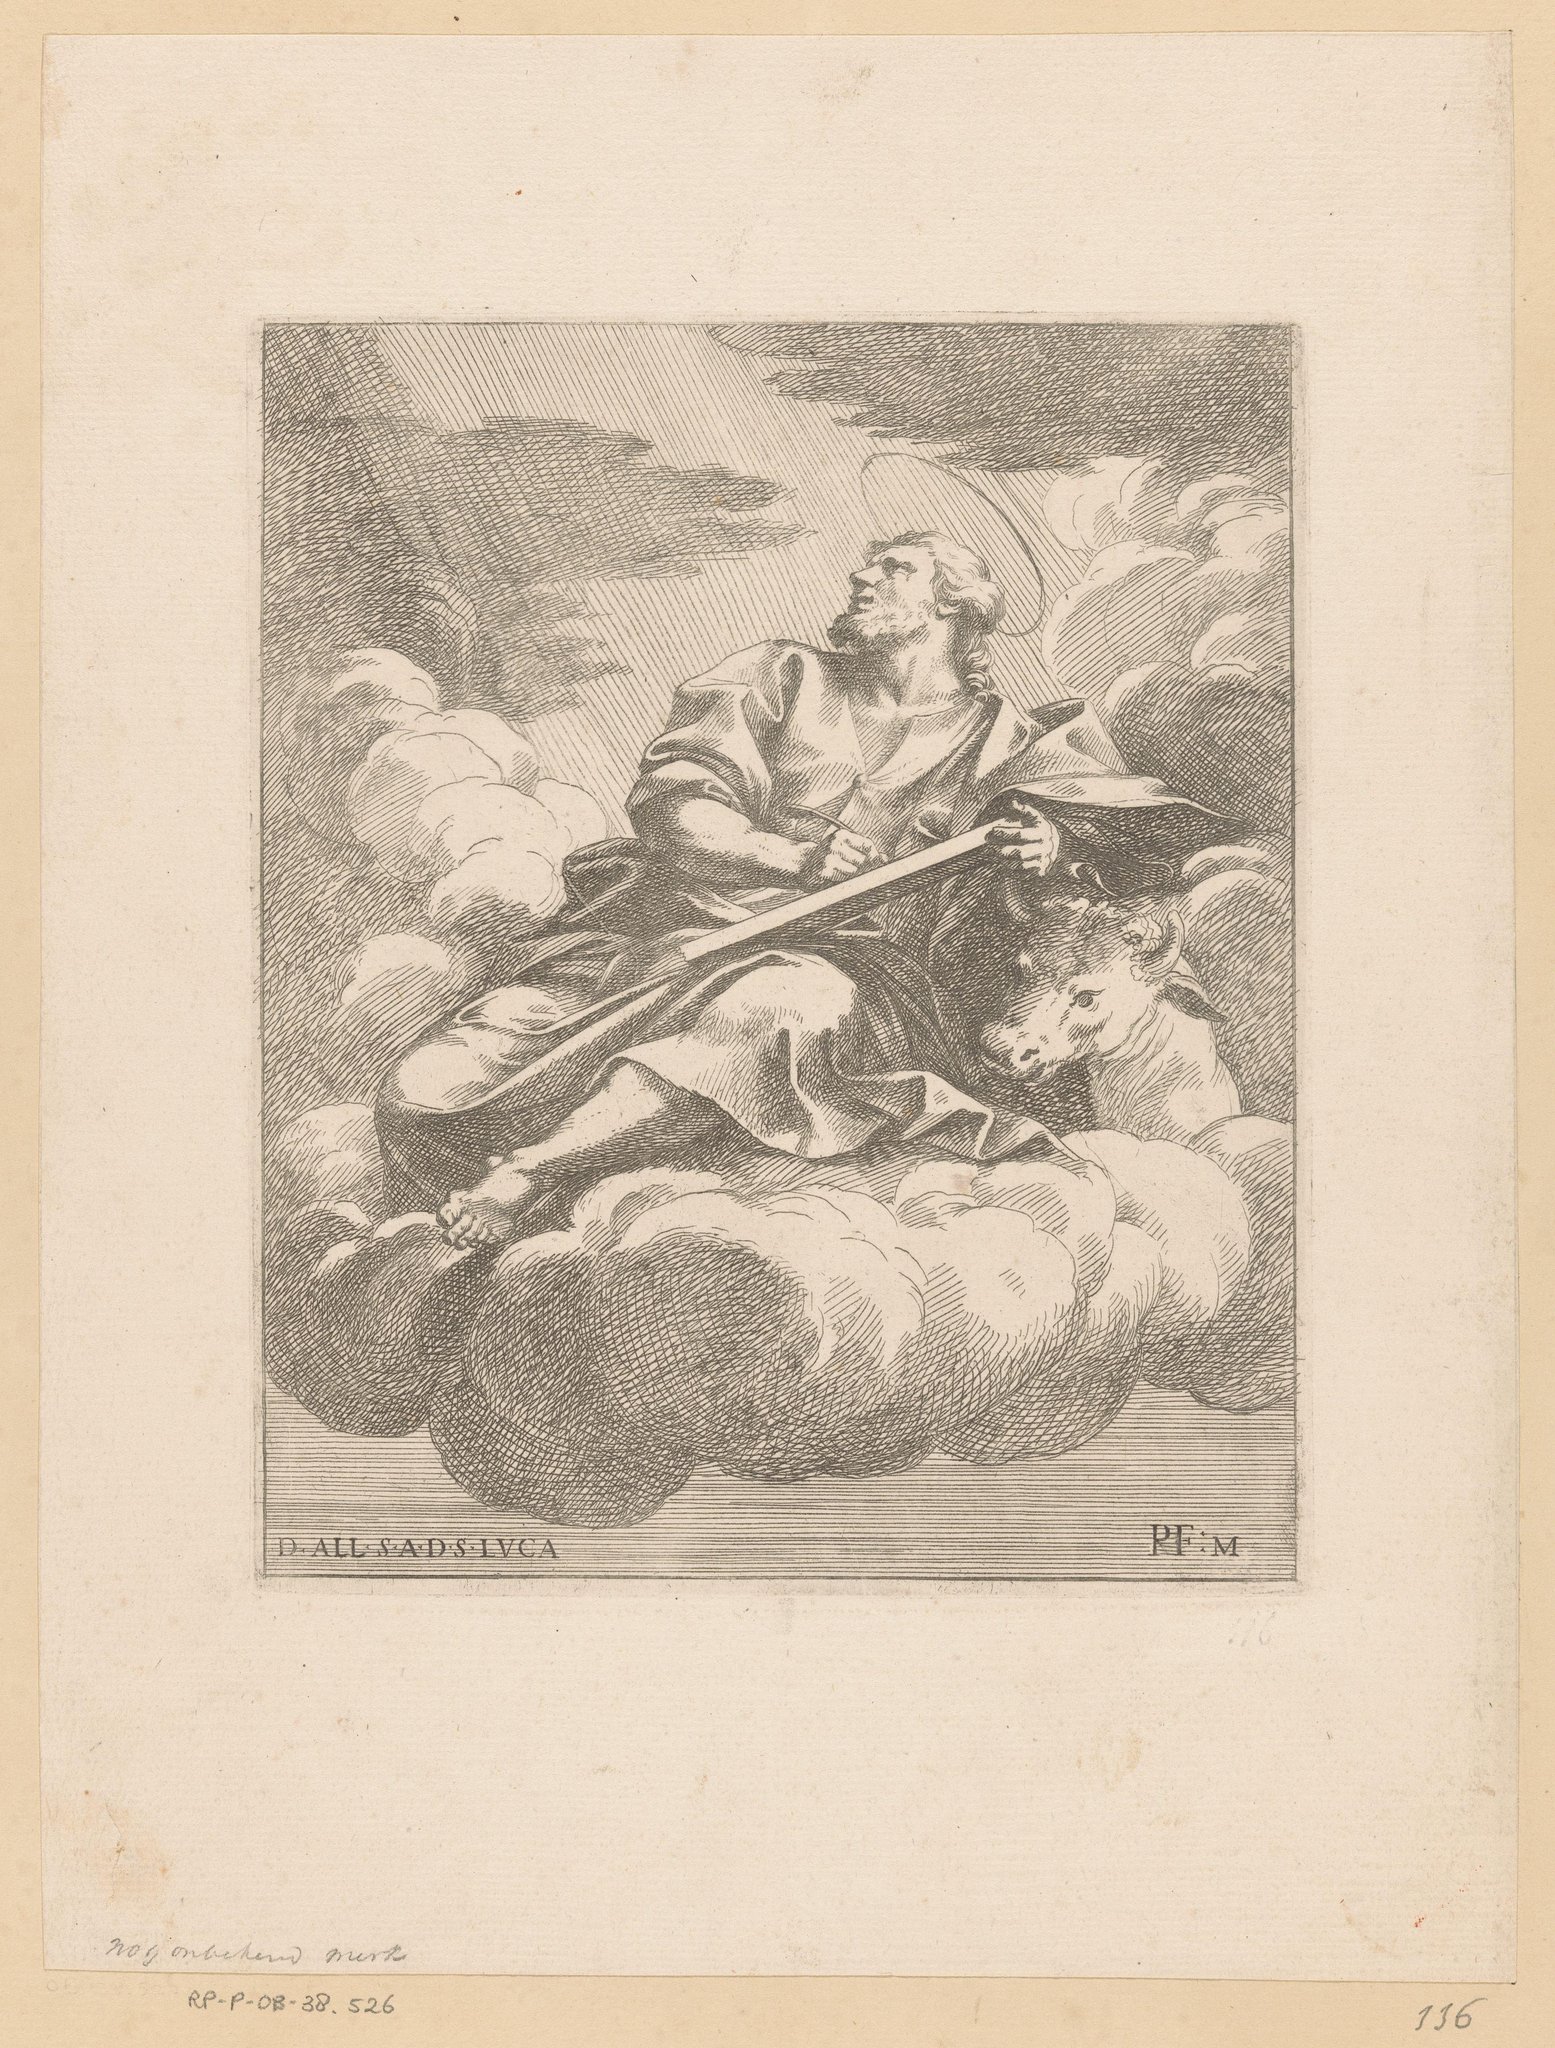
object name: print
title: Evangelist Lucas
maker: monogrammist rfm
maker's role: print maker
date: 1600-1699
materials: paper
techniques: etching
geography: italy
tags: st. luke writing his gospel, usually a (winged) ox present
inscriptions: collector's mark: Lugt 240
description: De evangelist Lucas zit schrijvend op een wolk. Hij leunt tegen de os.